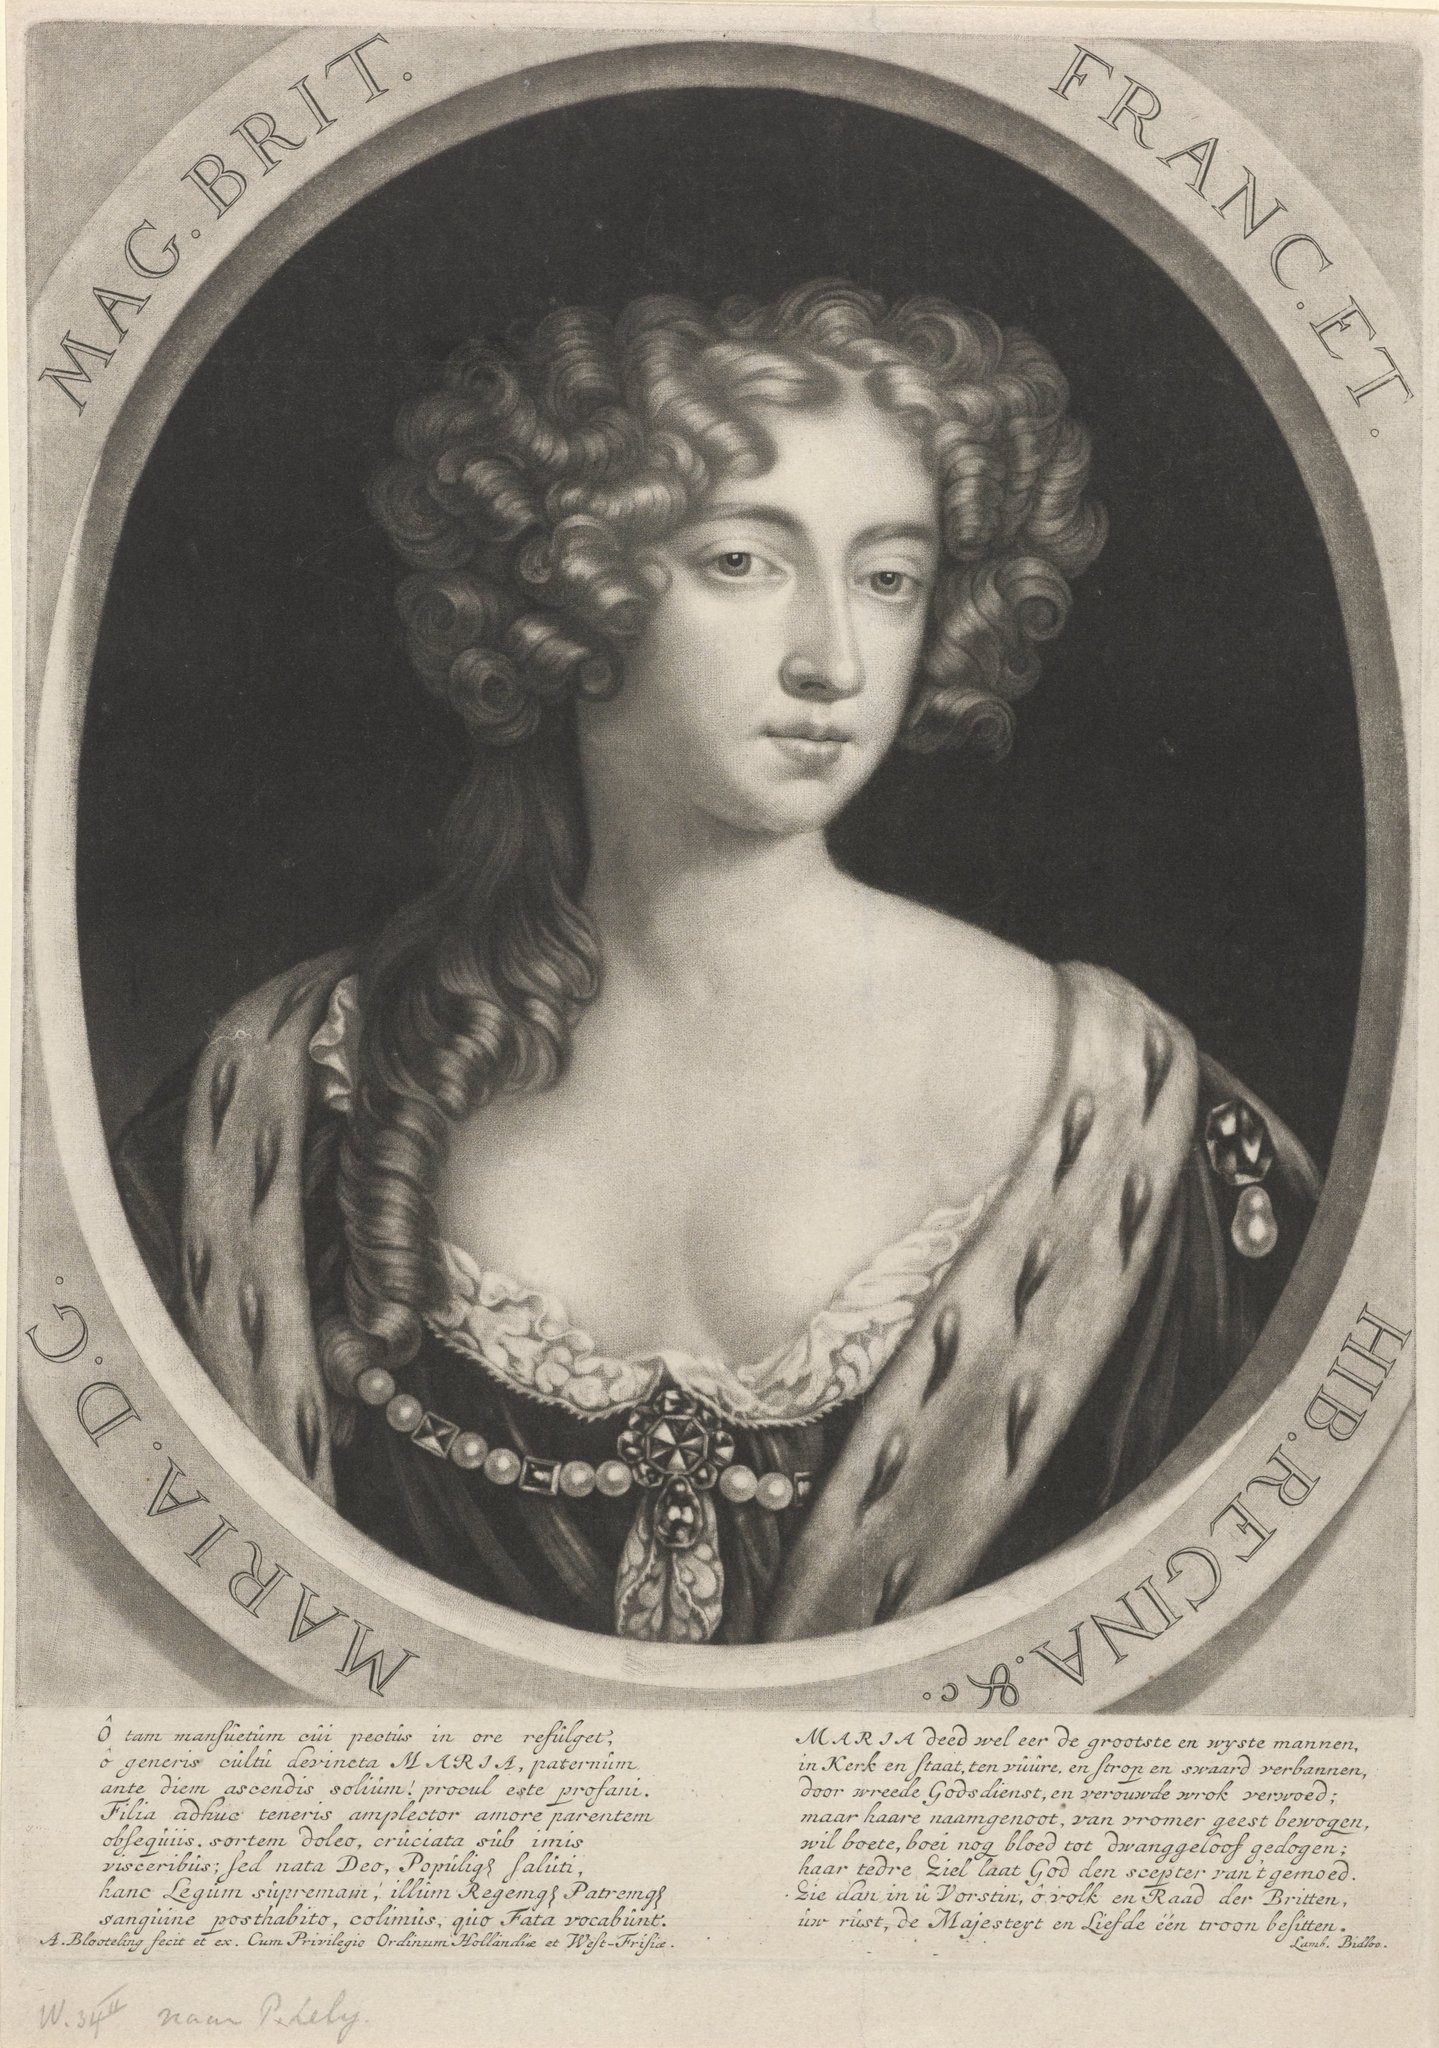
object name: print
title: Portret van Maria II Stuart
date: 1688-1690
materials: paper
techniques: mezzotint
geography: amsterdam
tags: london, maria ii stuart (koningin van engeland, schotland en ierland)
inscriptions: collector's mark: Lugt 2228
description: Portret van Maria II in een ovaal met randschrift. In de ondermarge acht regels Latijnse tekst en acht regels Nederlandse tekst.